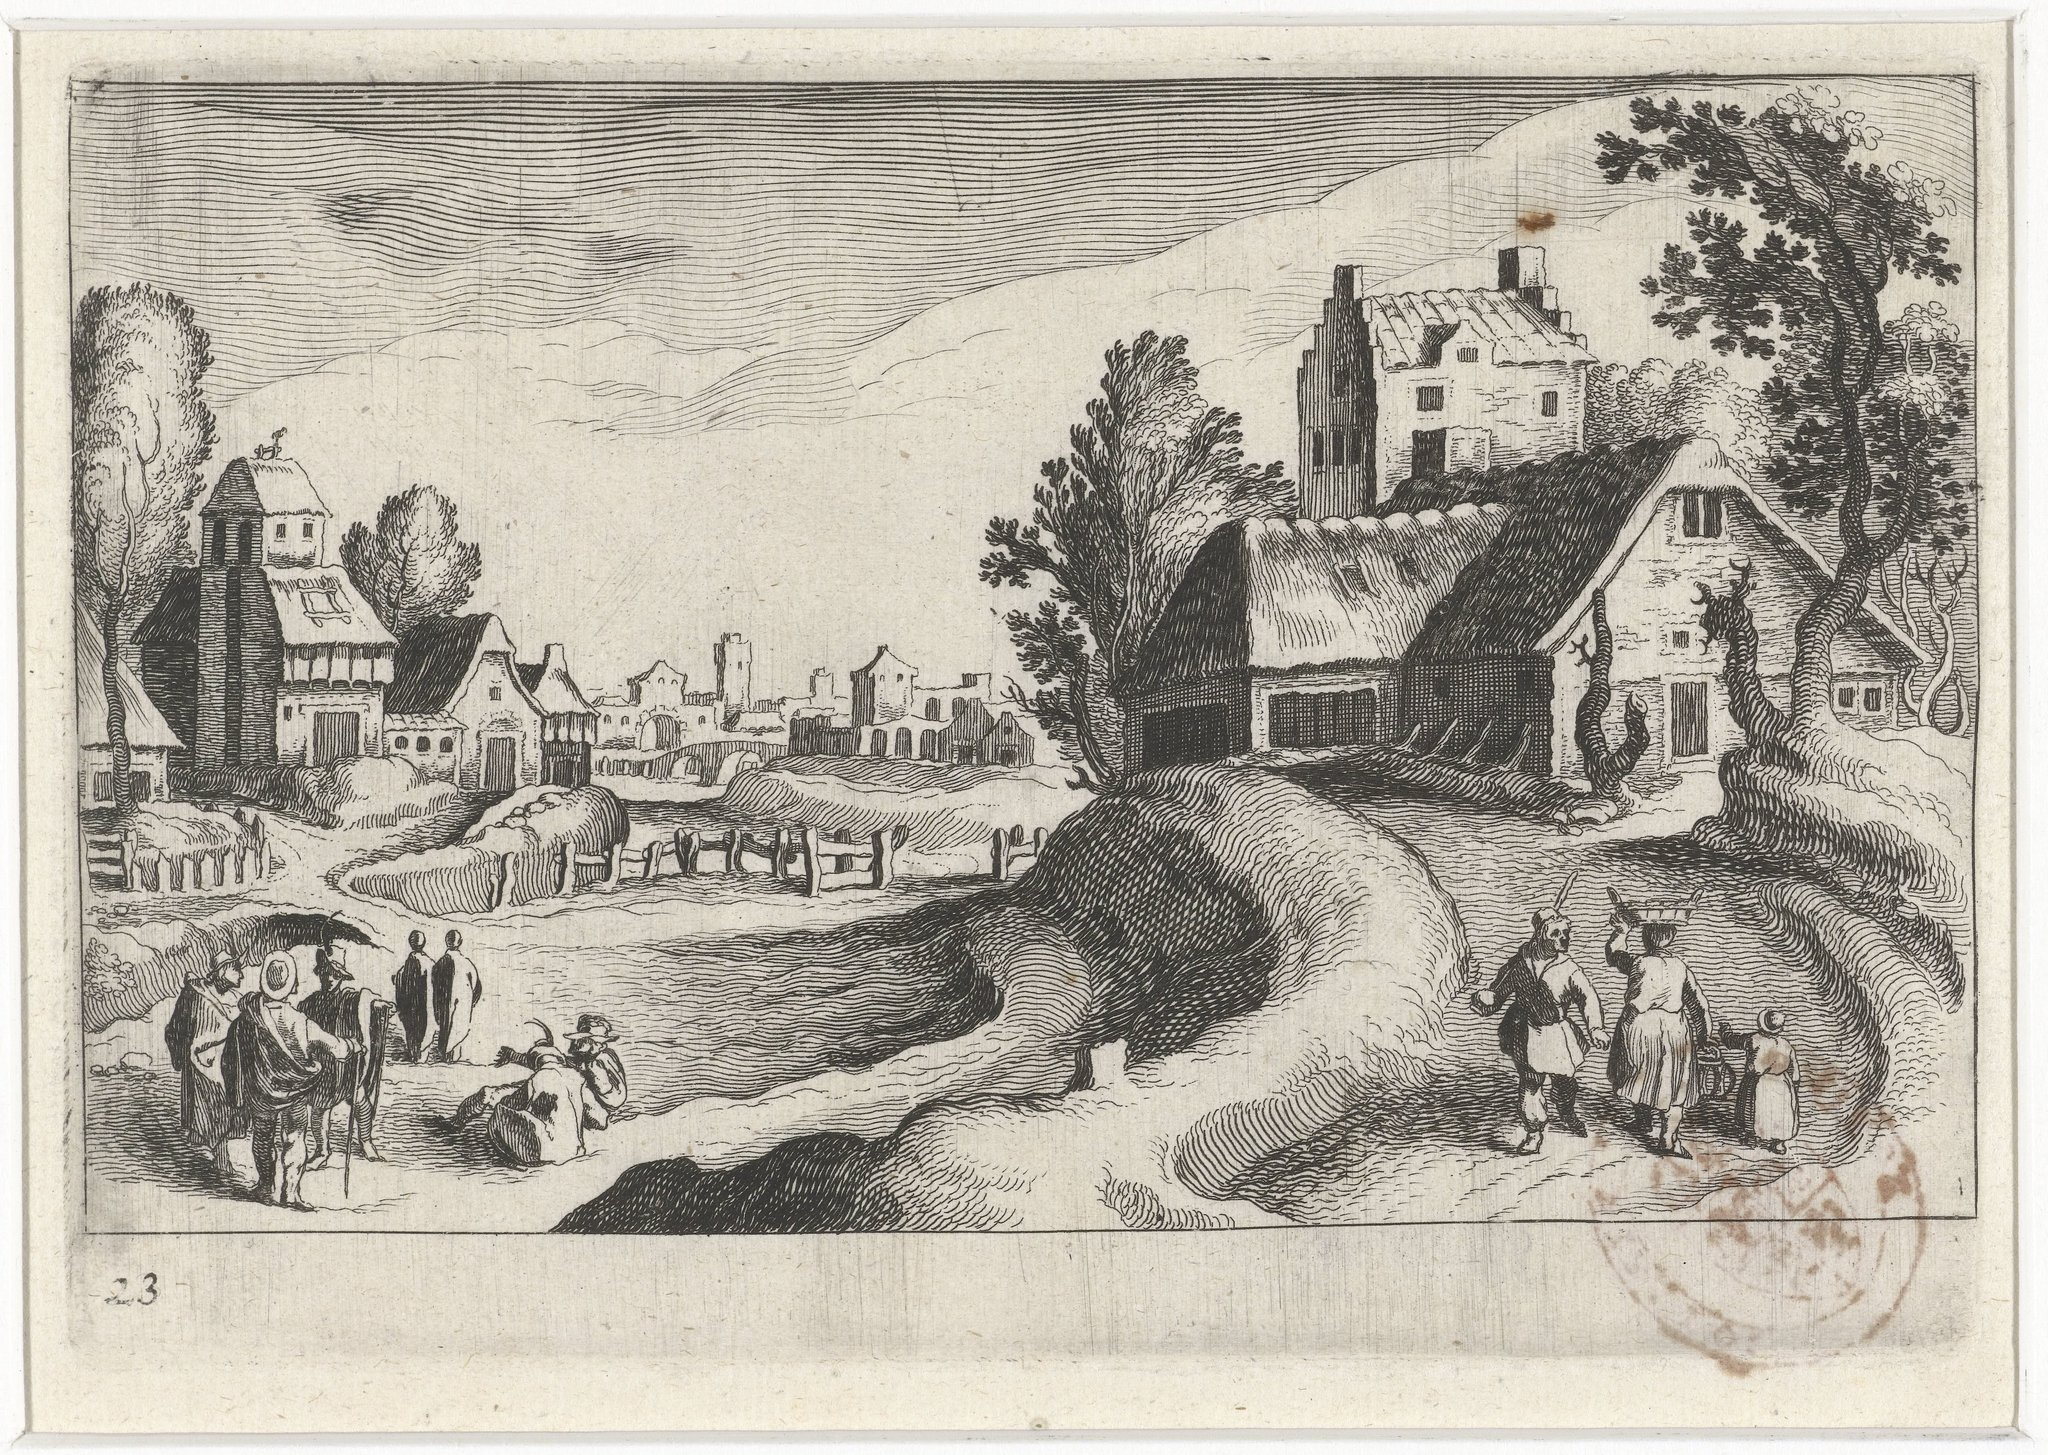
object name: print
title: Zuid-Europese landschappen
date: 1611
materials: paper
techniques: etching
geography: northern netherlands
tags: village (+ city(-scape) with figures, staffage)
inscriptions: collector's mark: Lugt 240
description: Rechts een grote boerderij. Vooraan enkele figuren op een pad. Op de achtergrond een dorp.